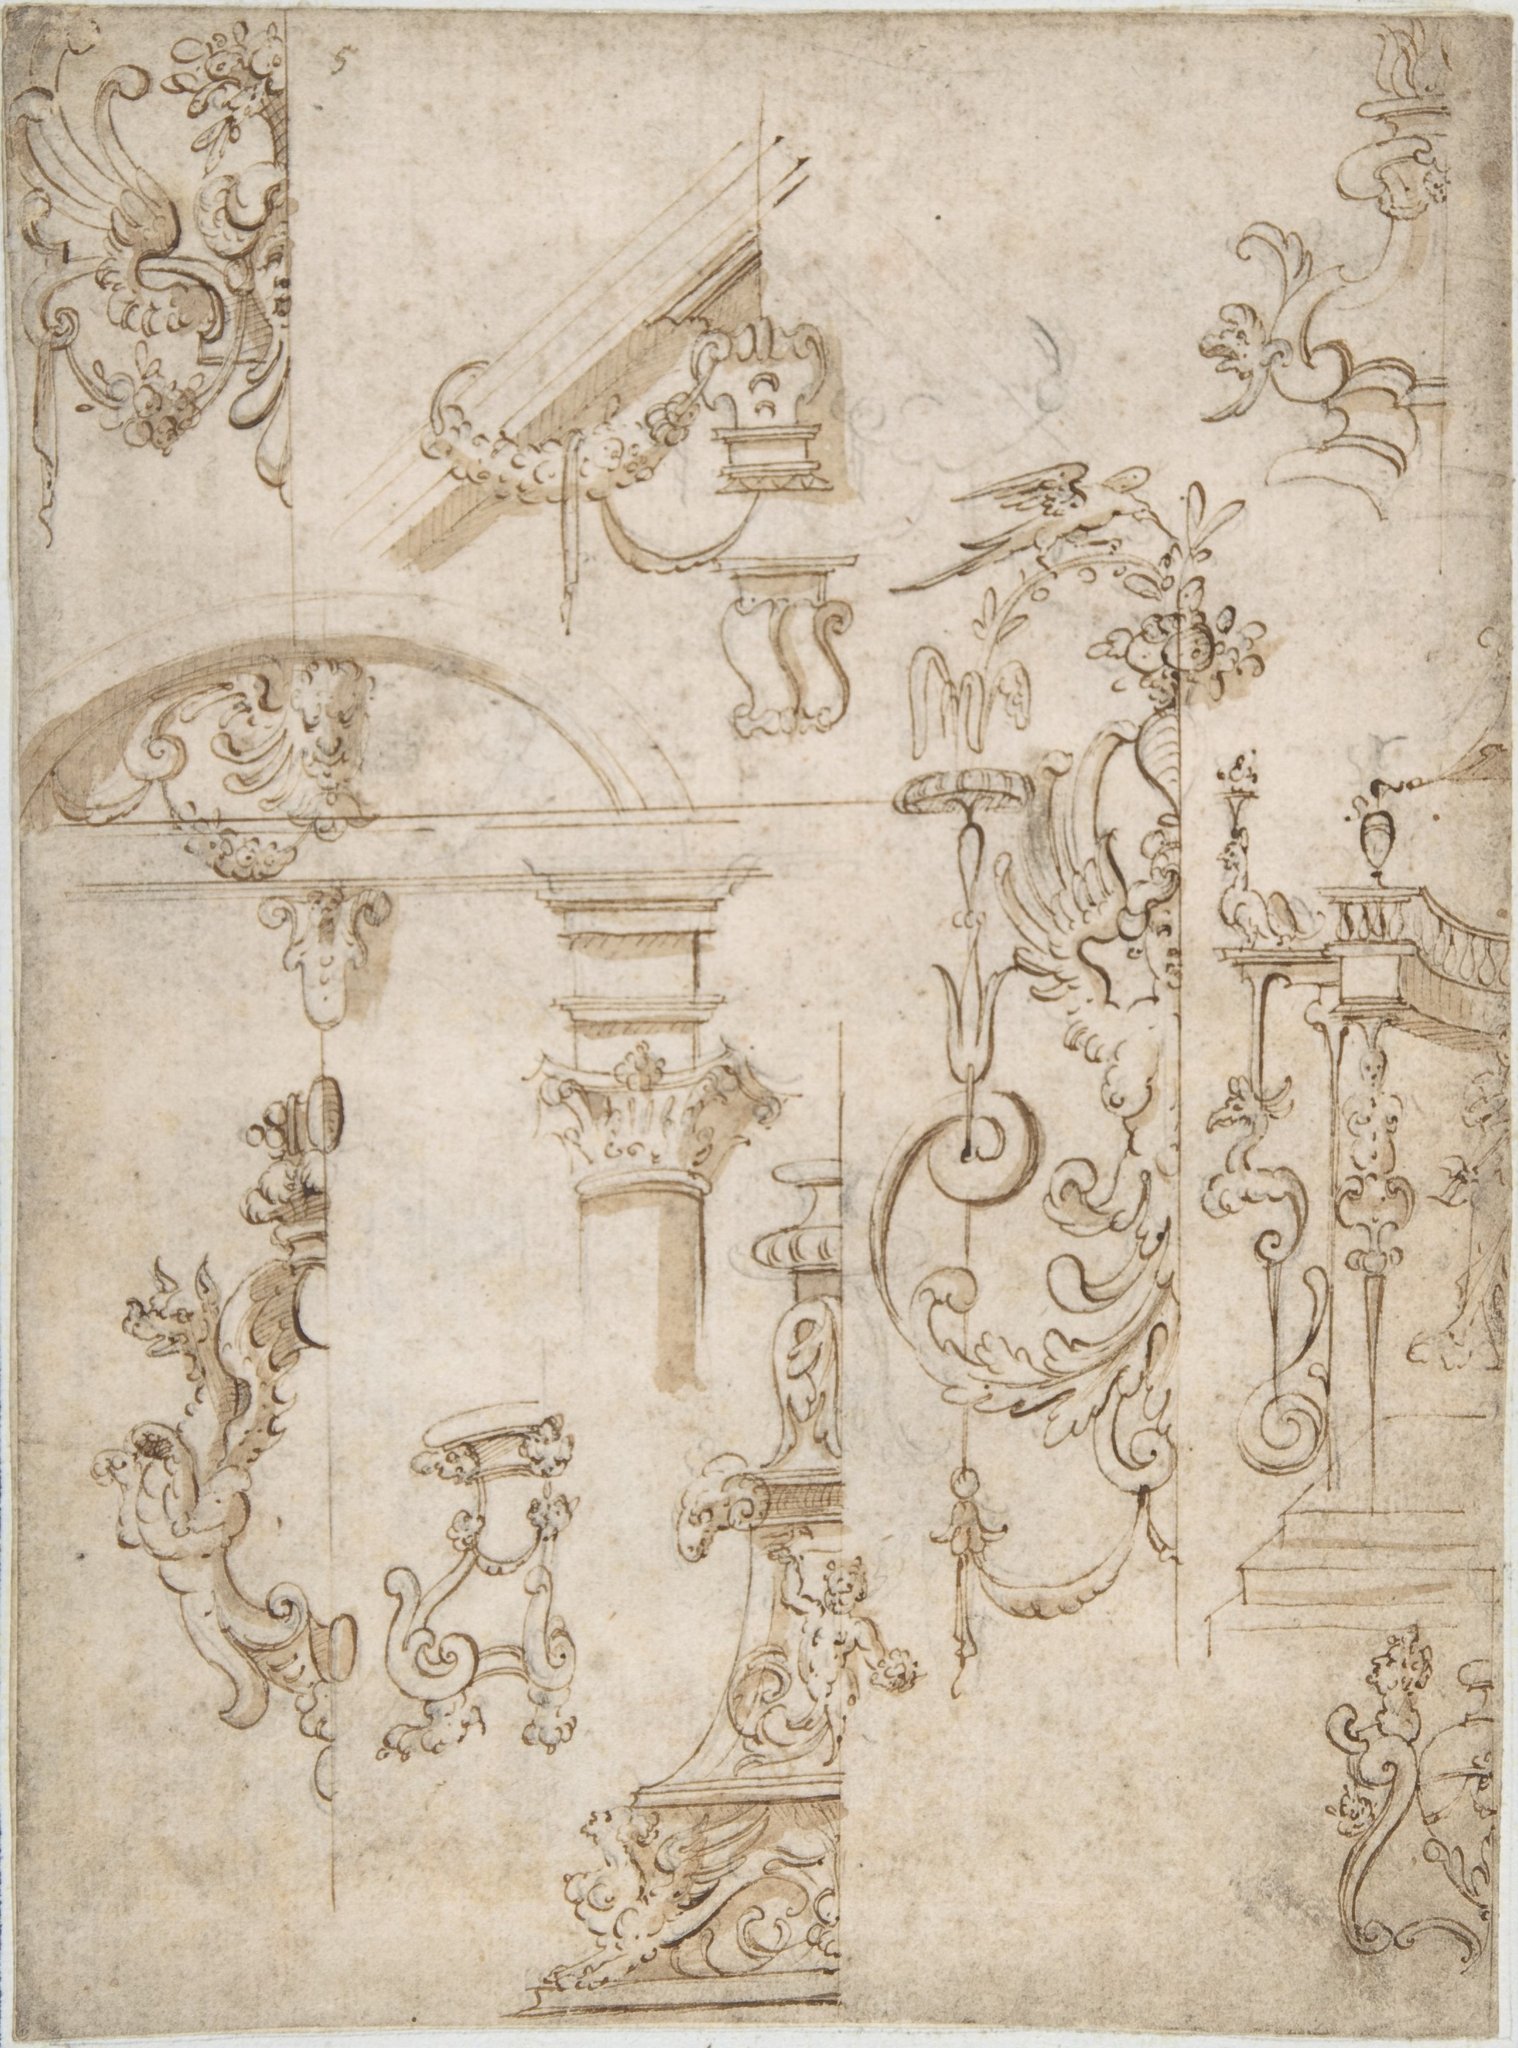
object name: ornament architecture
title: Ornamental sketches with a Griffin and Architectural Elements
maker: anonymous, french, 16th century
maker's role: artist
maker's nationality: french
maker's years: 1500-1600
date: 1501-1600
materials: chalk, ink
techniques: brush, pen, wash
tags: ornament,griffins